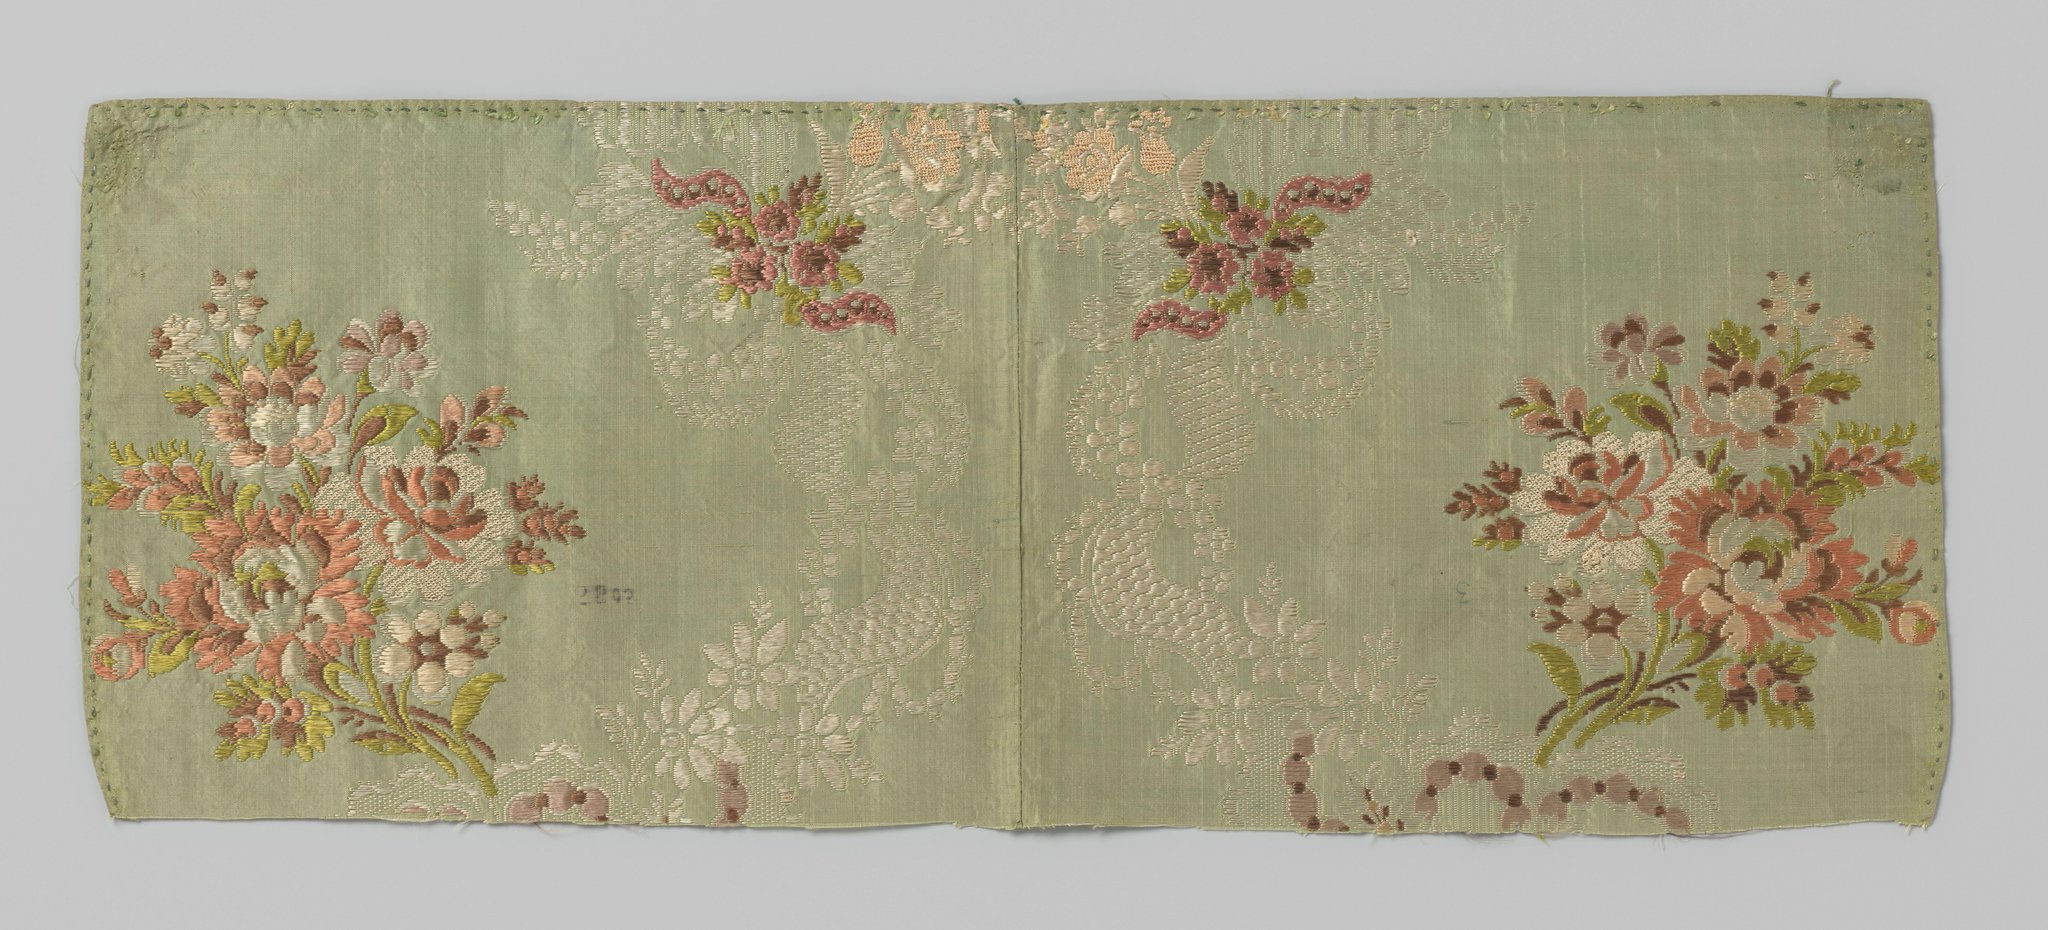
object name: fragment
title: Fragment veelkleurige gebrocheerde zijde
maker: Anonymous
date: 1740-1760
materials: silk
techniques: brocade, weave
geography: france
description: Fragment veelkleurig zijdeweefsel. Een groene grond heeft een patroon van witte kantslingers met bloemen en vruchten, waartussen gekleurde bloemboeketten en bloemtakken. Twee aan elkaar genaaide stukken.